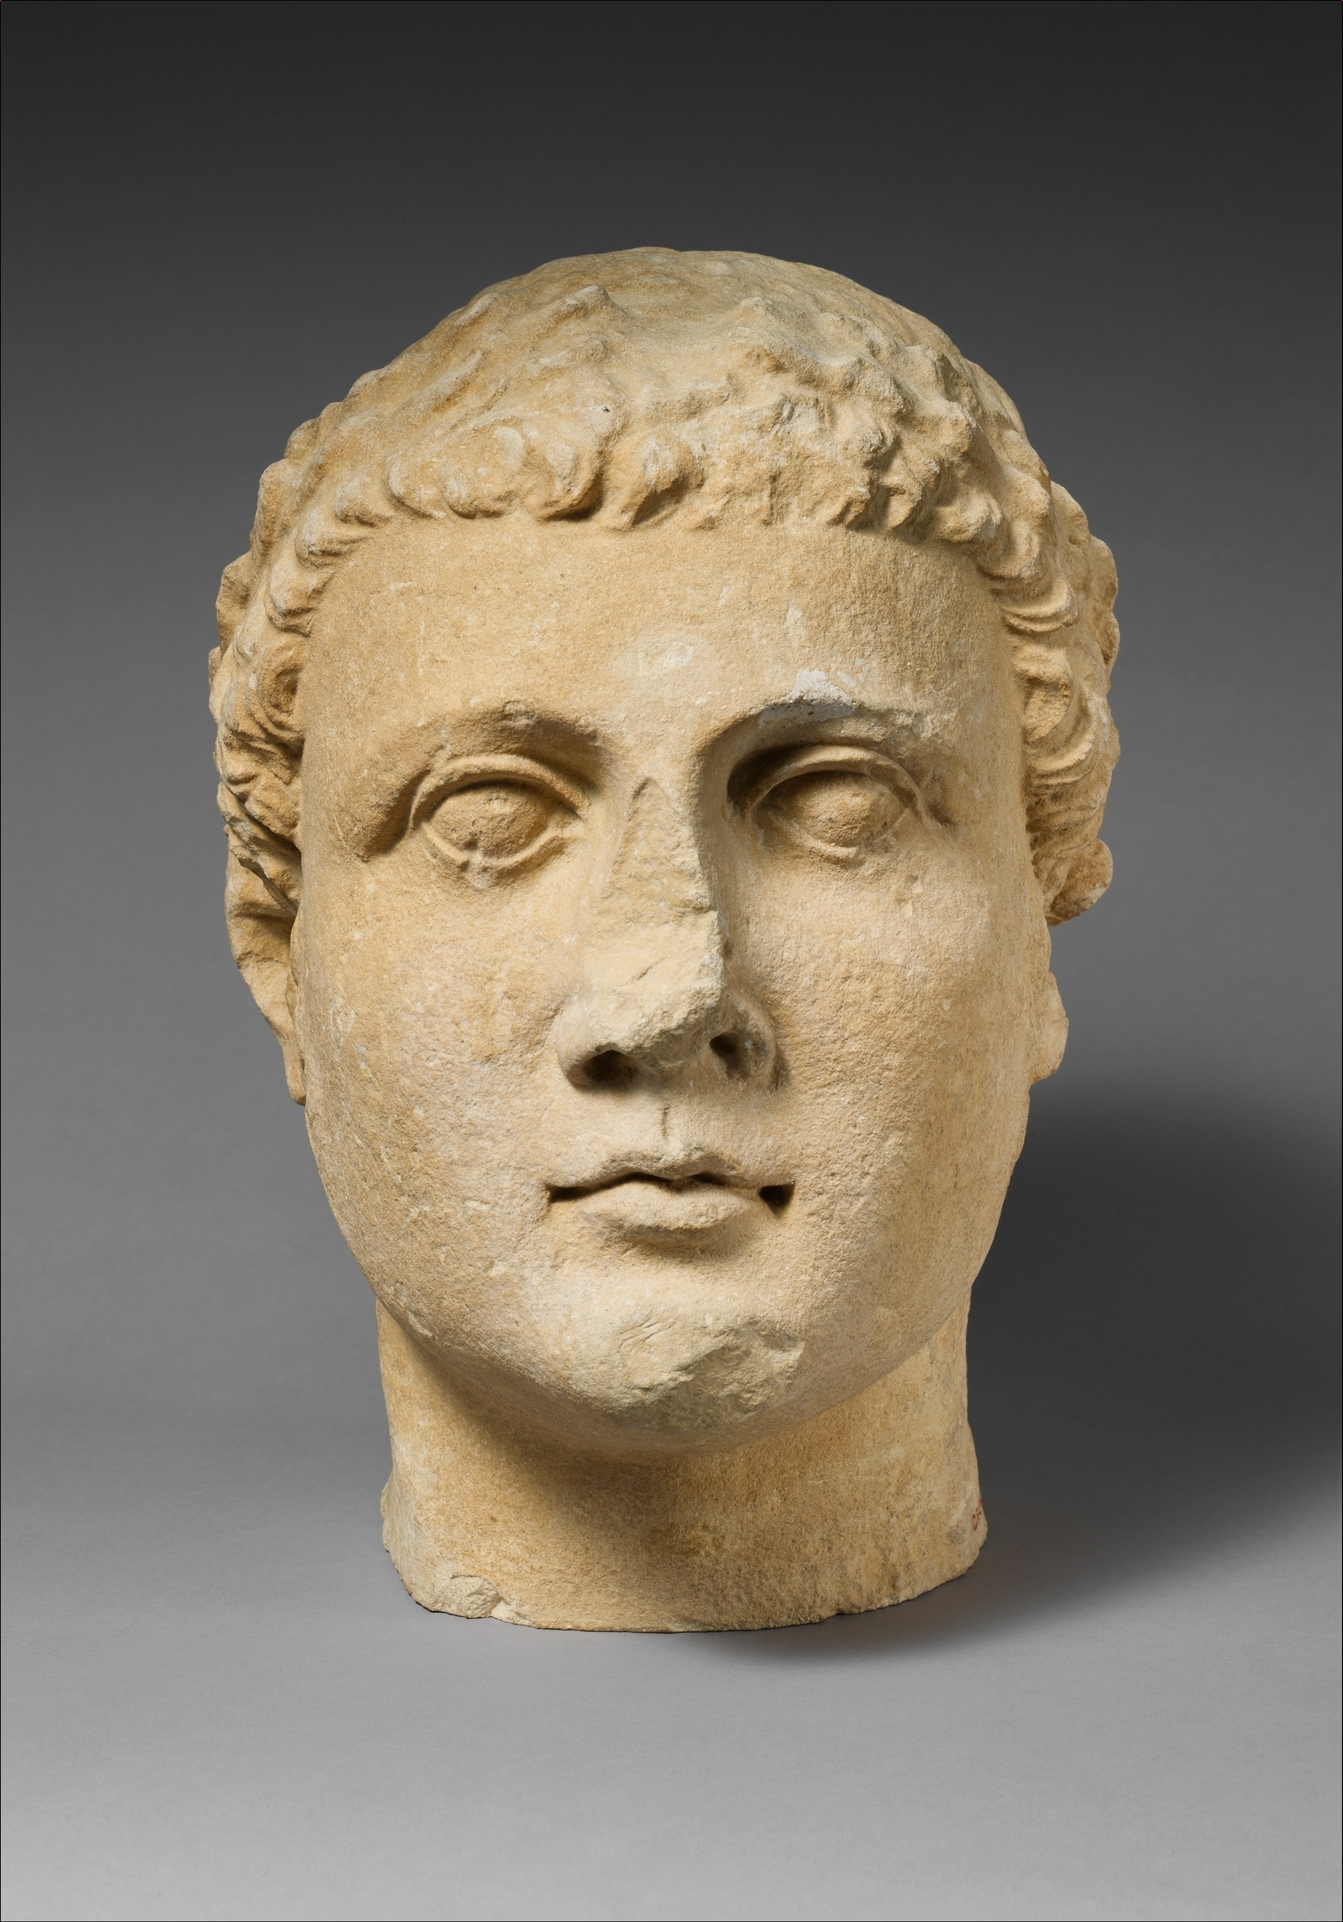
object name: head of a votary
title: Limestone head of beardless male votary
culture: cypriot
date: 300-101 BCE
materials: limestone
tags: heads,men